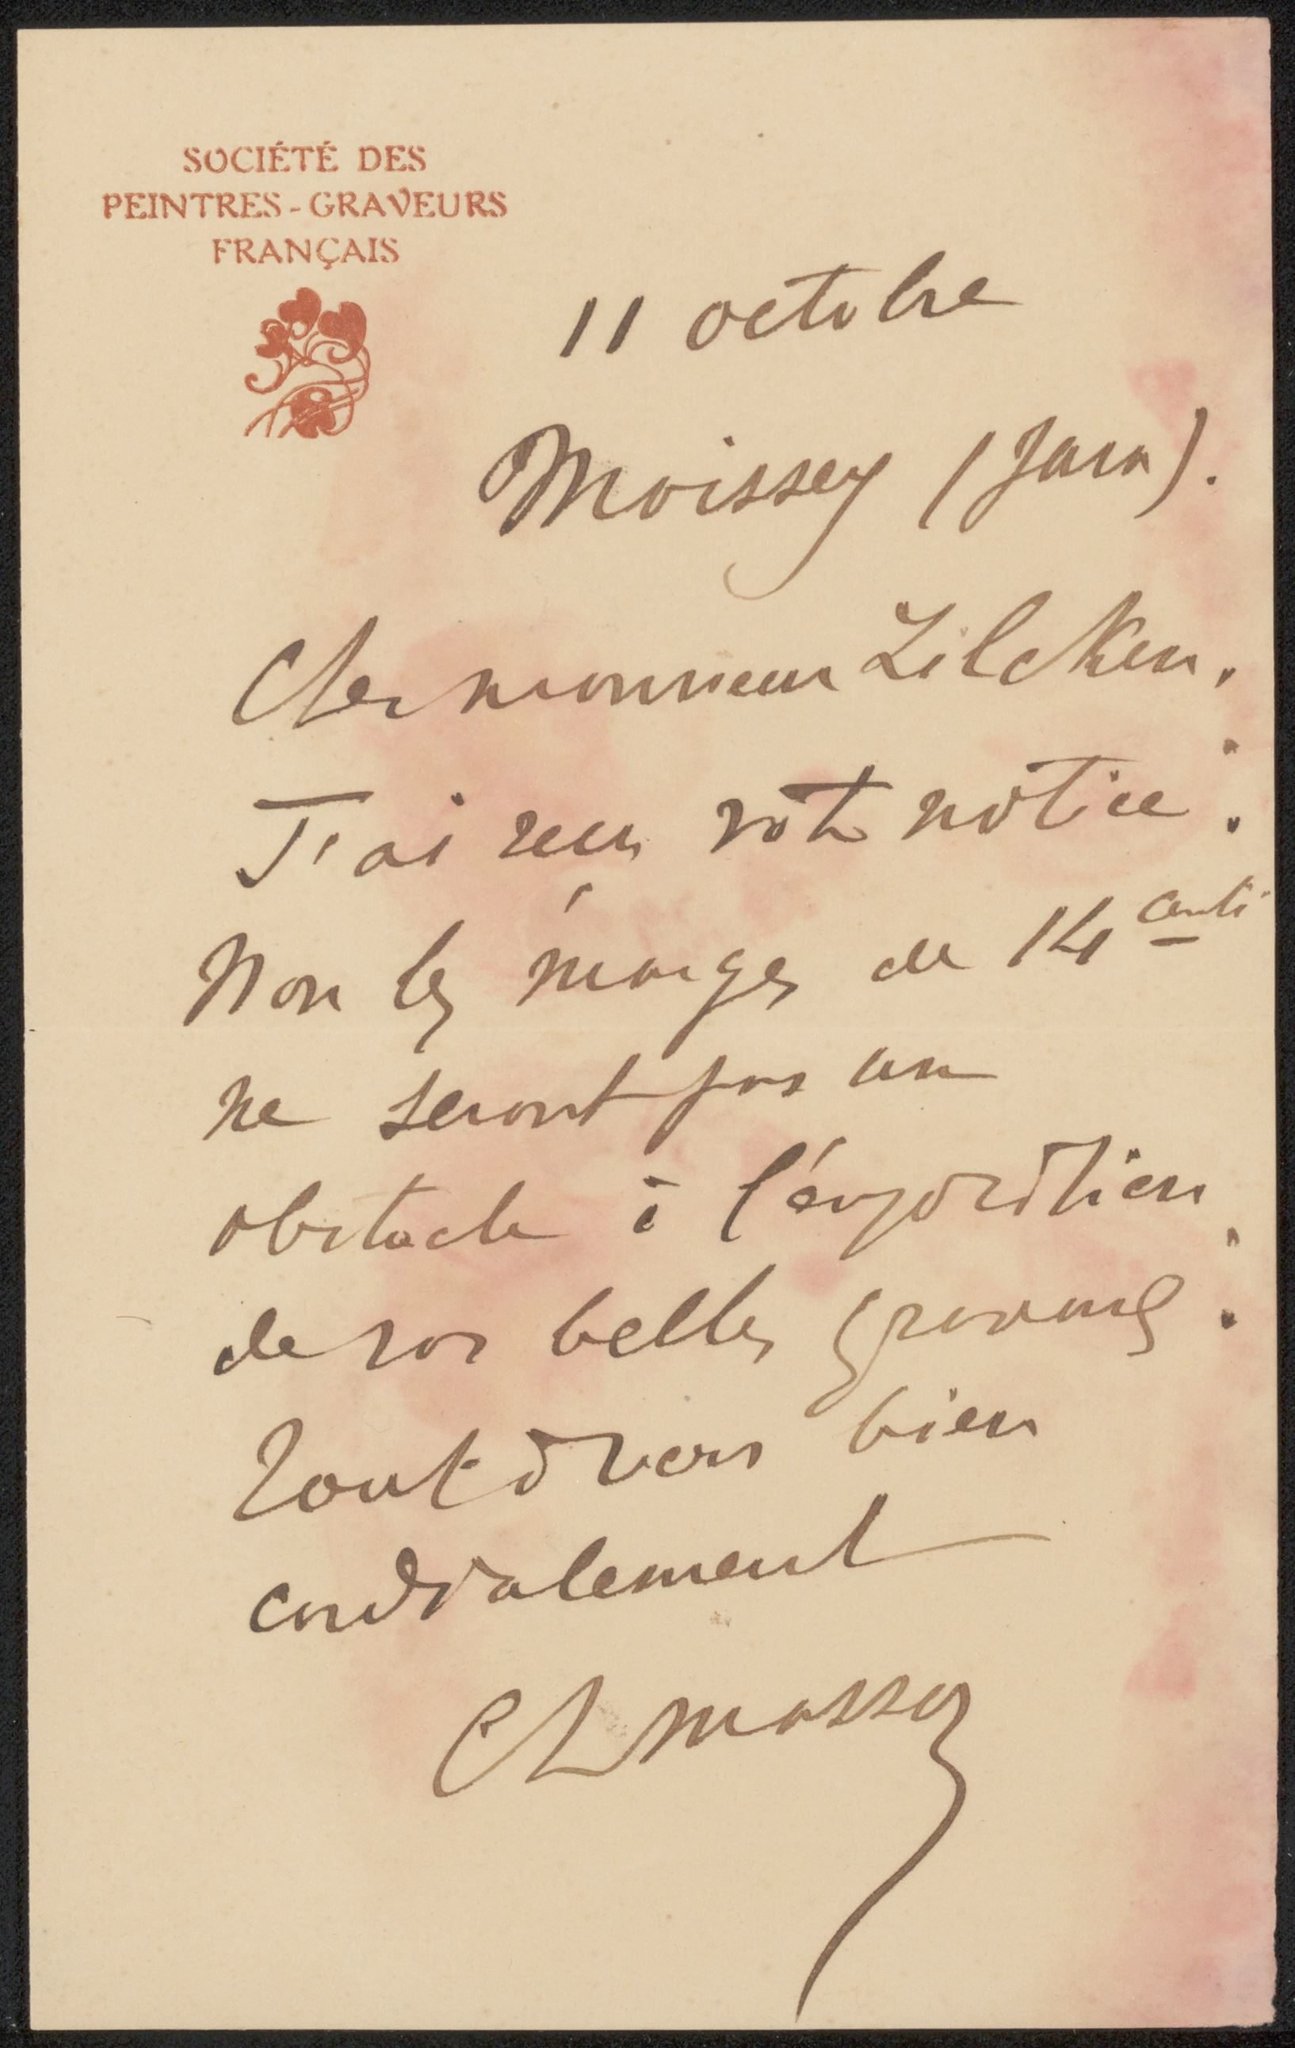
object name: letter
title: Brief aan Philip Zilcken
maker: charles masson (uitgever)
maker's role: publisher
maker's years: 1858-1931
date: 1910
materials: ink, paper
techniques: pen, printing, writing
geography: moissey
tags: painter, draughtsman, philip zilcken, the graphic arts, exhibition ~ art, paris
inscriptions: collector's mark: ‘RPK’, watermark